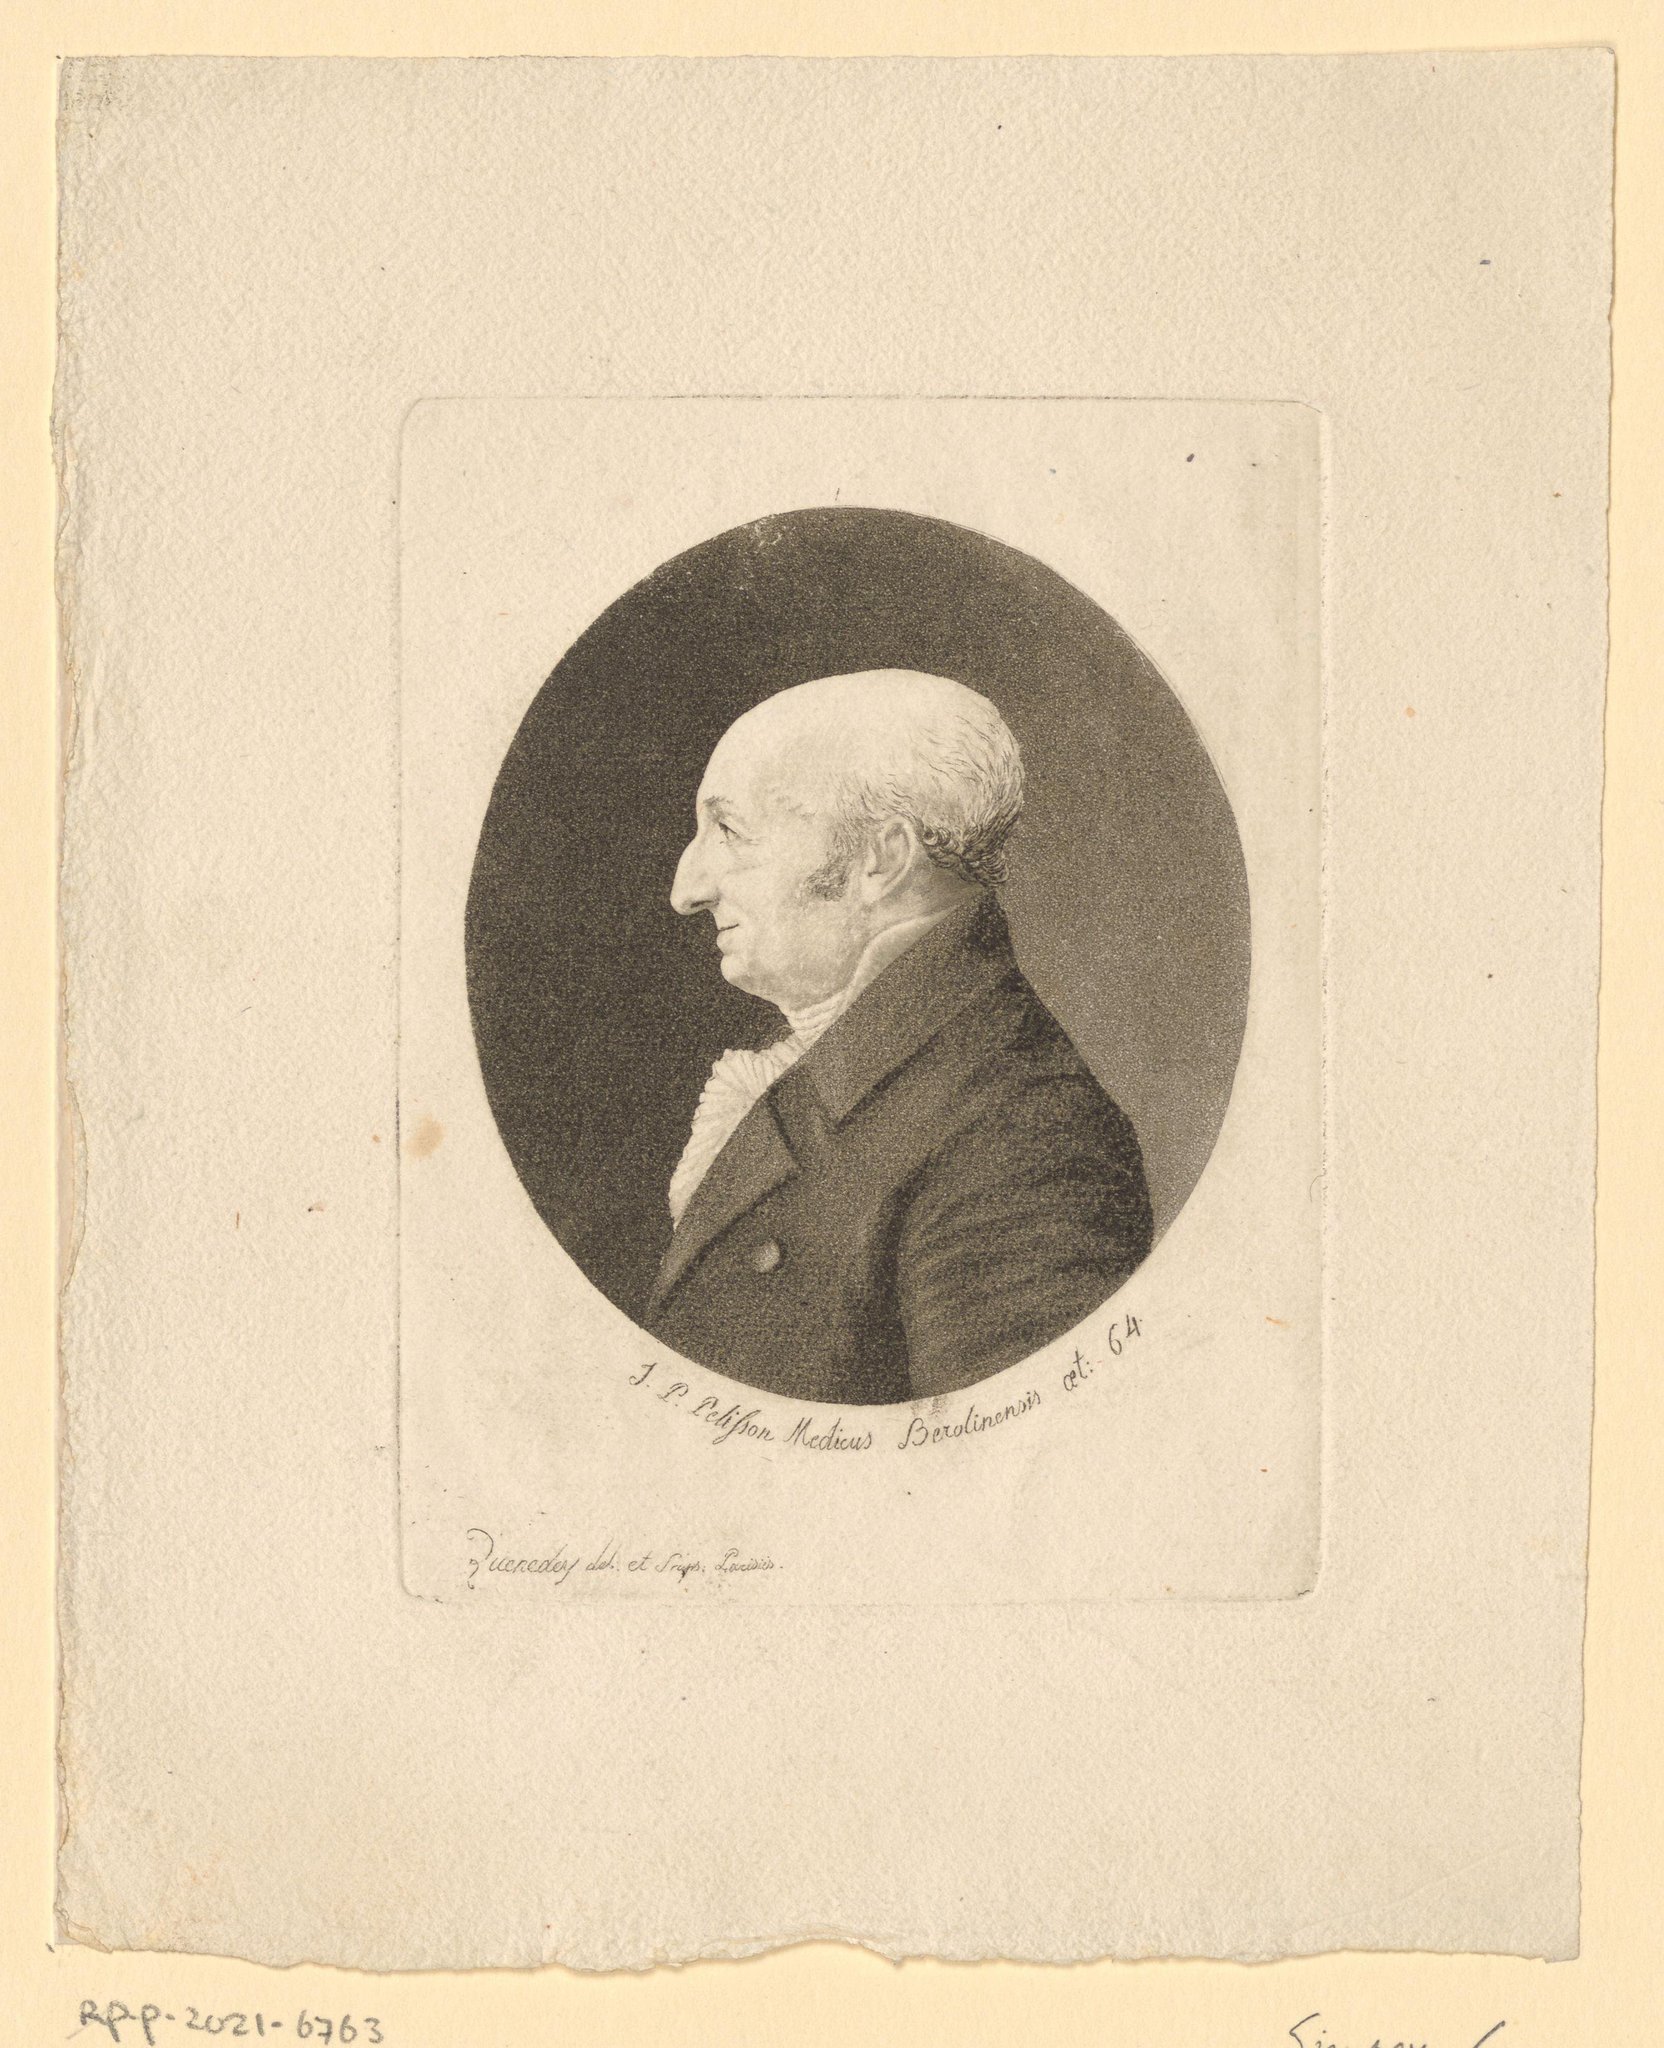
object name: print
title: Portret van Jacob Philipp Pelisson op 64-jarige leeftijd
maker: edme quenedey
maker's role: print maker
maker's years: 1756-1830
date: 1807-1824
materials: paper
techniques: aquatint, etching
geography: paris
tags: adult man, historical persons, physician, doctor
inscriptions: inscription: ‘14m’